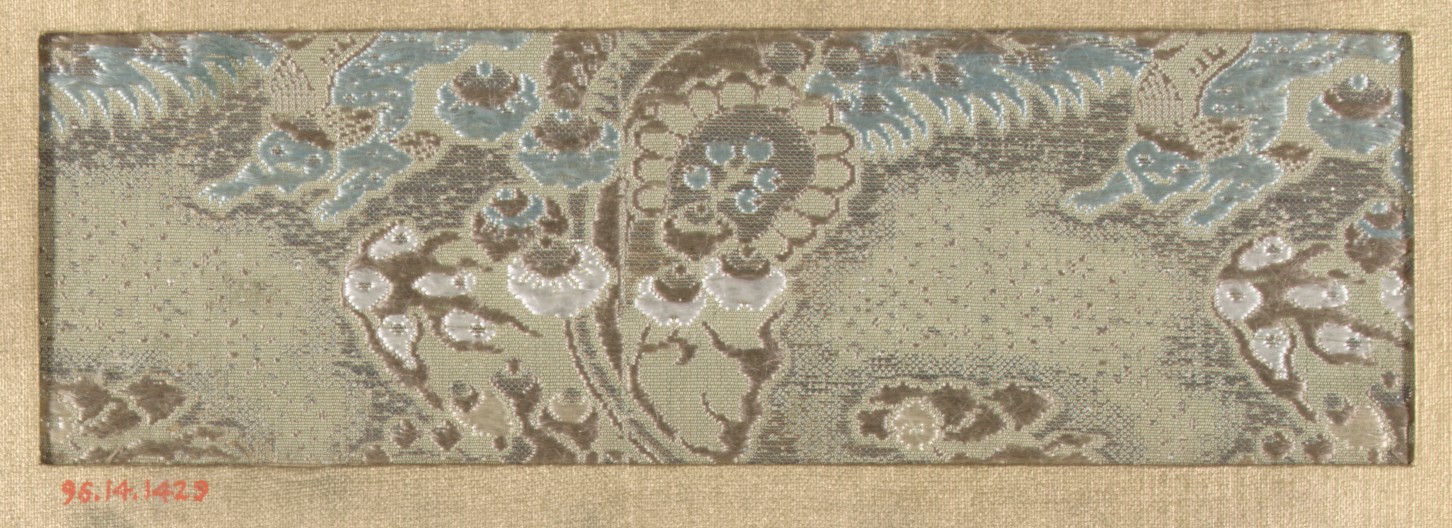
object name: piece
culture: japanese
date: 1701-1900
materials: silk